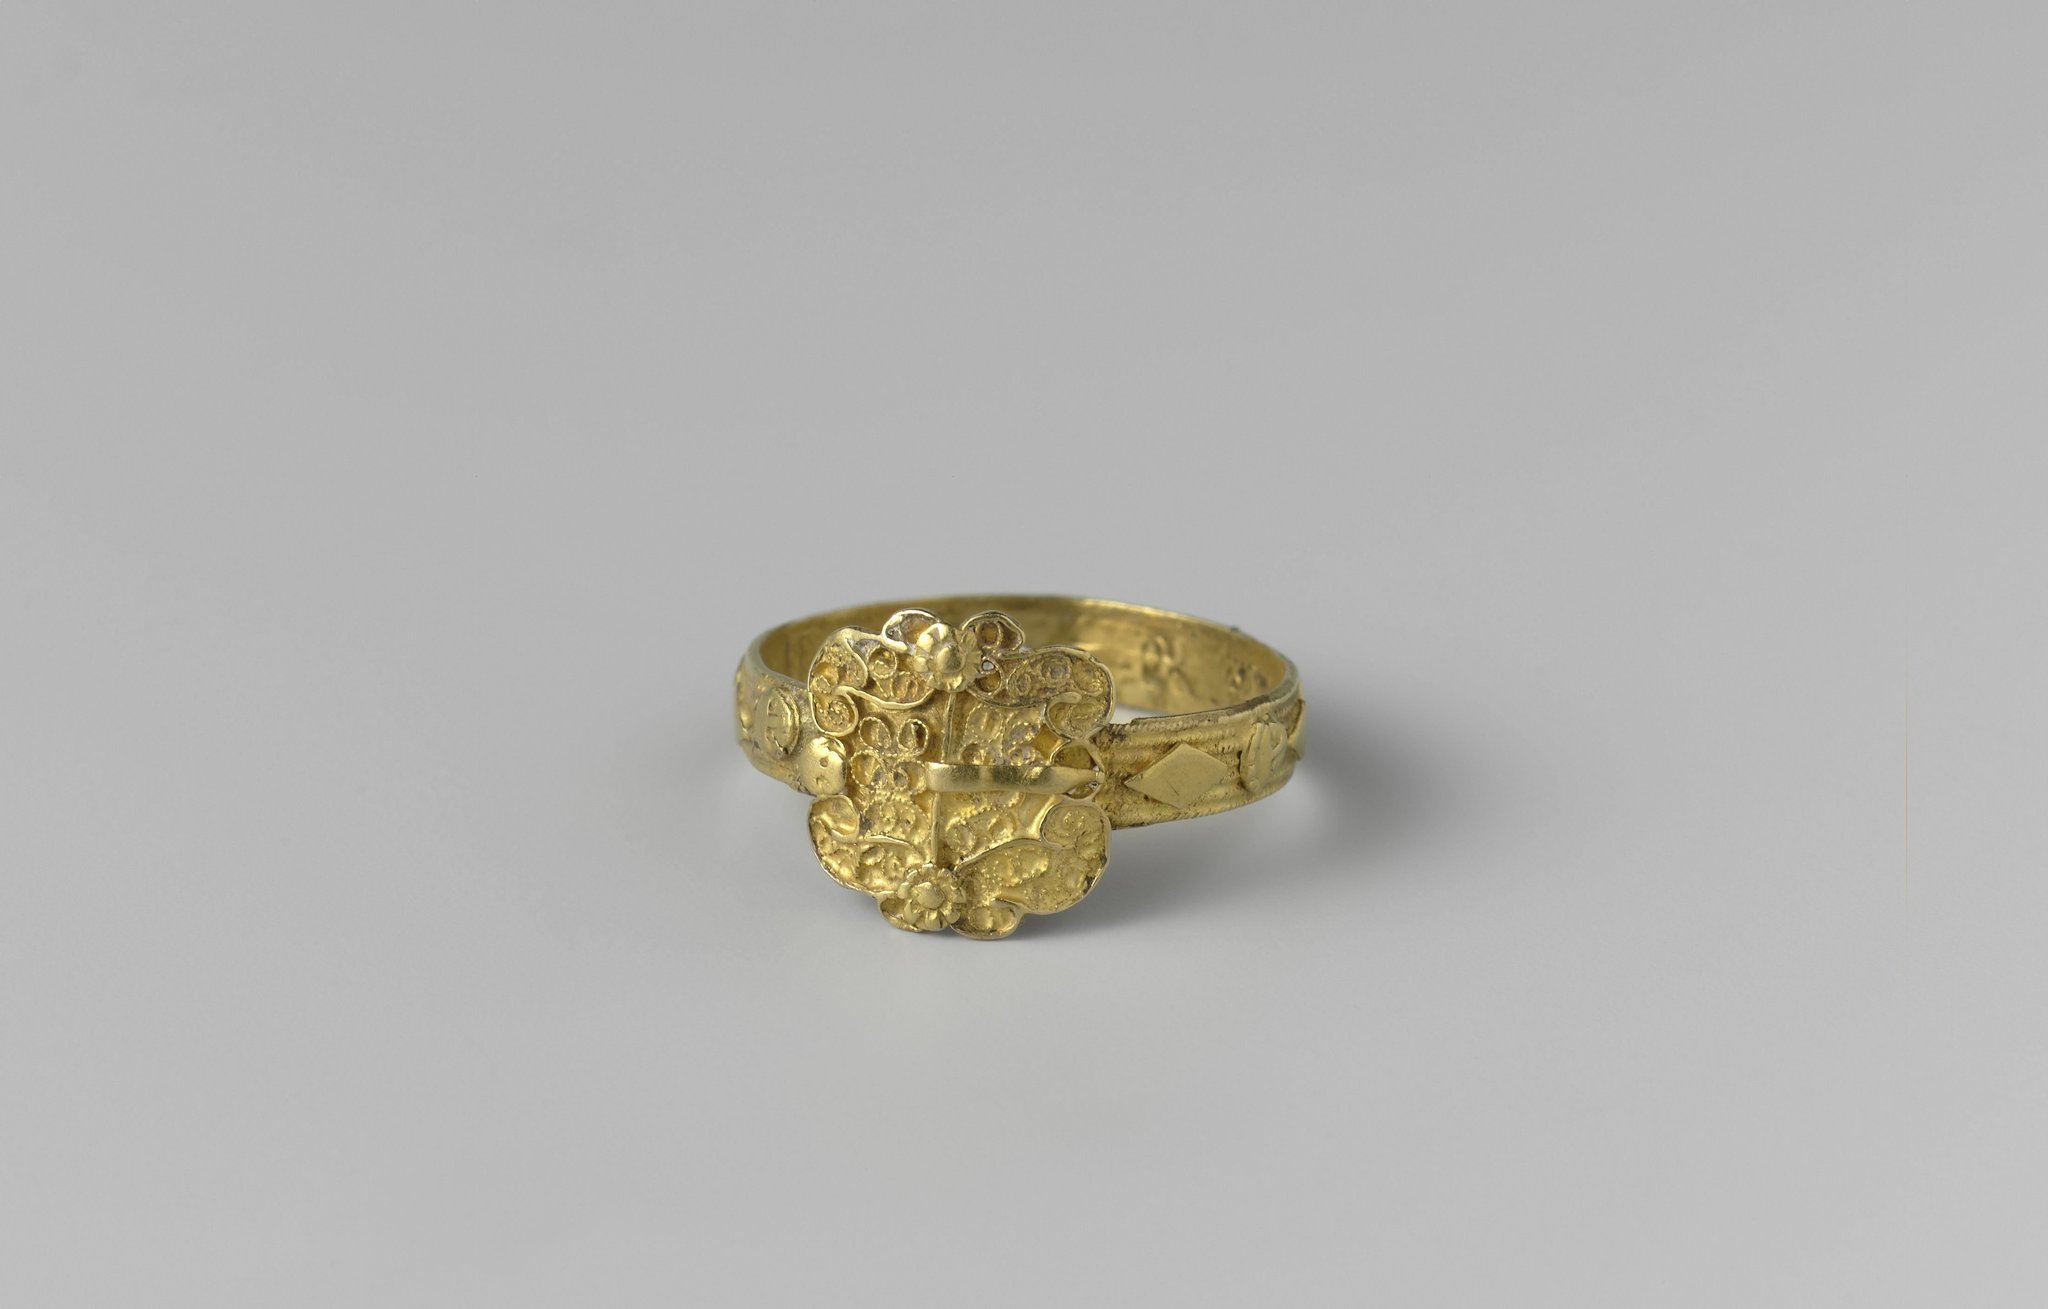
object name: ring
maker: pierre daniel bellanger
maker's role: goldsmith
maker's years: 1699-1768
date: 1727-1768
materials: gold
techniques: filigree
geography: amsterdam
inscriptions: date letter, town mark, alloy mark, maker's mark: ‘P.B. (Citroen 1975, nr. 725)’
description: Ring van goud. De gecanneleerde band is versierd met afwisselend ruiten en kopjes. Aan de bovenkant van de ring is een met filigrein bewerkte fantasiegesp bevestigd.